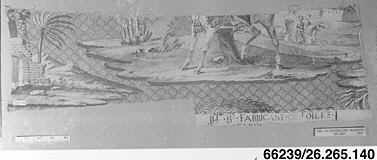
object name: piece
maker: louis-henri brevière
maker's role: designer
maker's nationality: french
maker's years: 1797-1869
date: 1823-1829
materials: cotton